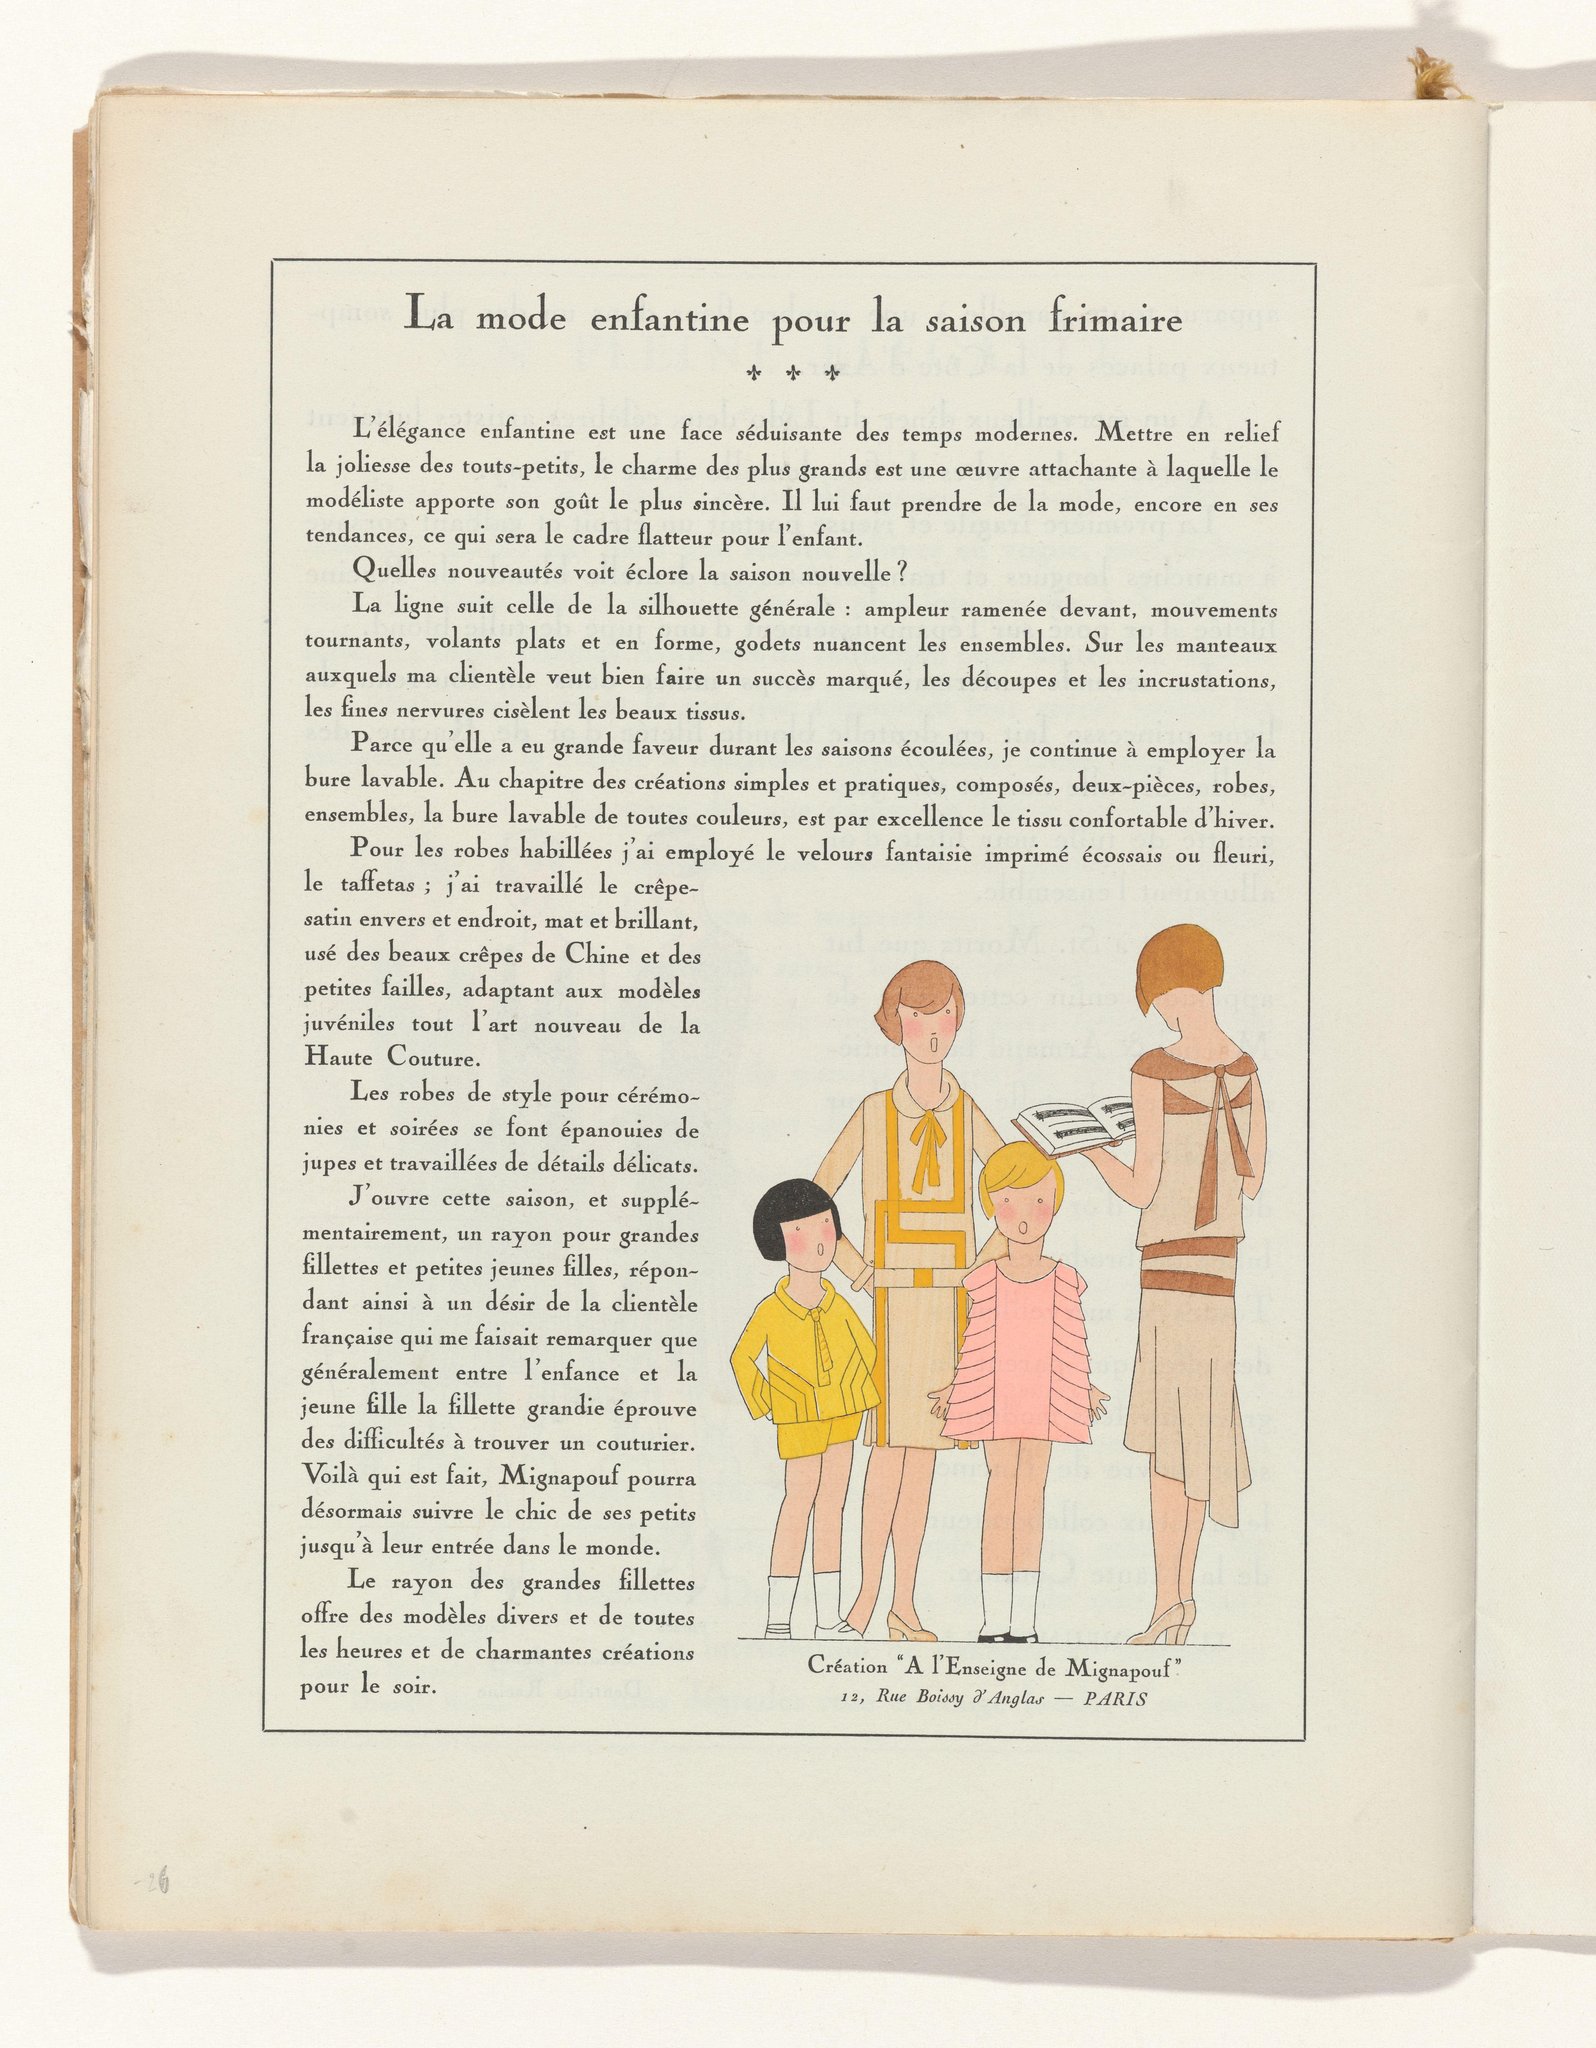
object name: fashion print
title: Art - Goût - Beauté, Feuillets de l' élégance féminine, Novembre 1928, No. 99, 9e Année, p. 26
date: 1928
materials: paper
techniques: hand coloring, lithograph, pochoir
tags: notation of music, fashion plates, children singing, dress, gown (+ girls' clothes)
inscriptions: title: ‘La mode enfantine pour la saison frimaire’, caption: ‘Création "A l'Enseigne de Mignapouf`." / 12, Rue Boissy d'Anglas - PARIS’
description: Tekst "La mode enfantine pour le saison frimaire" met afbeelding van zingende kinderen. Ontwerp van "A l'Enseigne de Mignapouf". Pagina uit het modetijdschrift Art-Goût-Beauté (1920-1933).